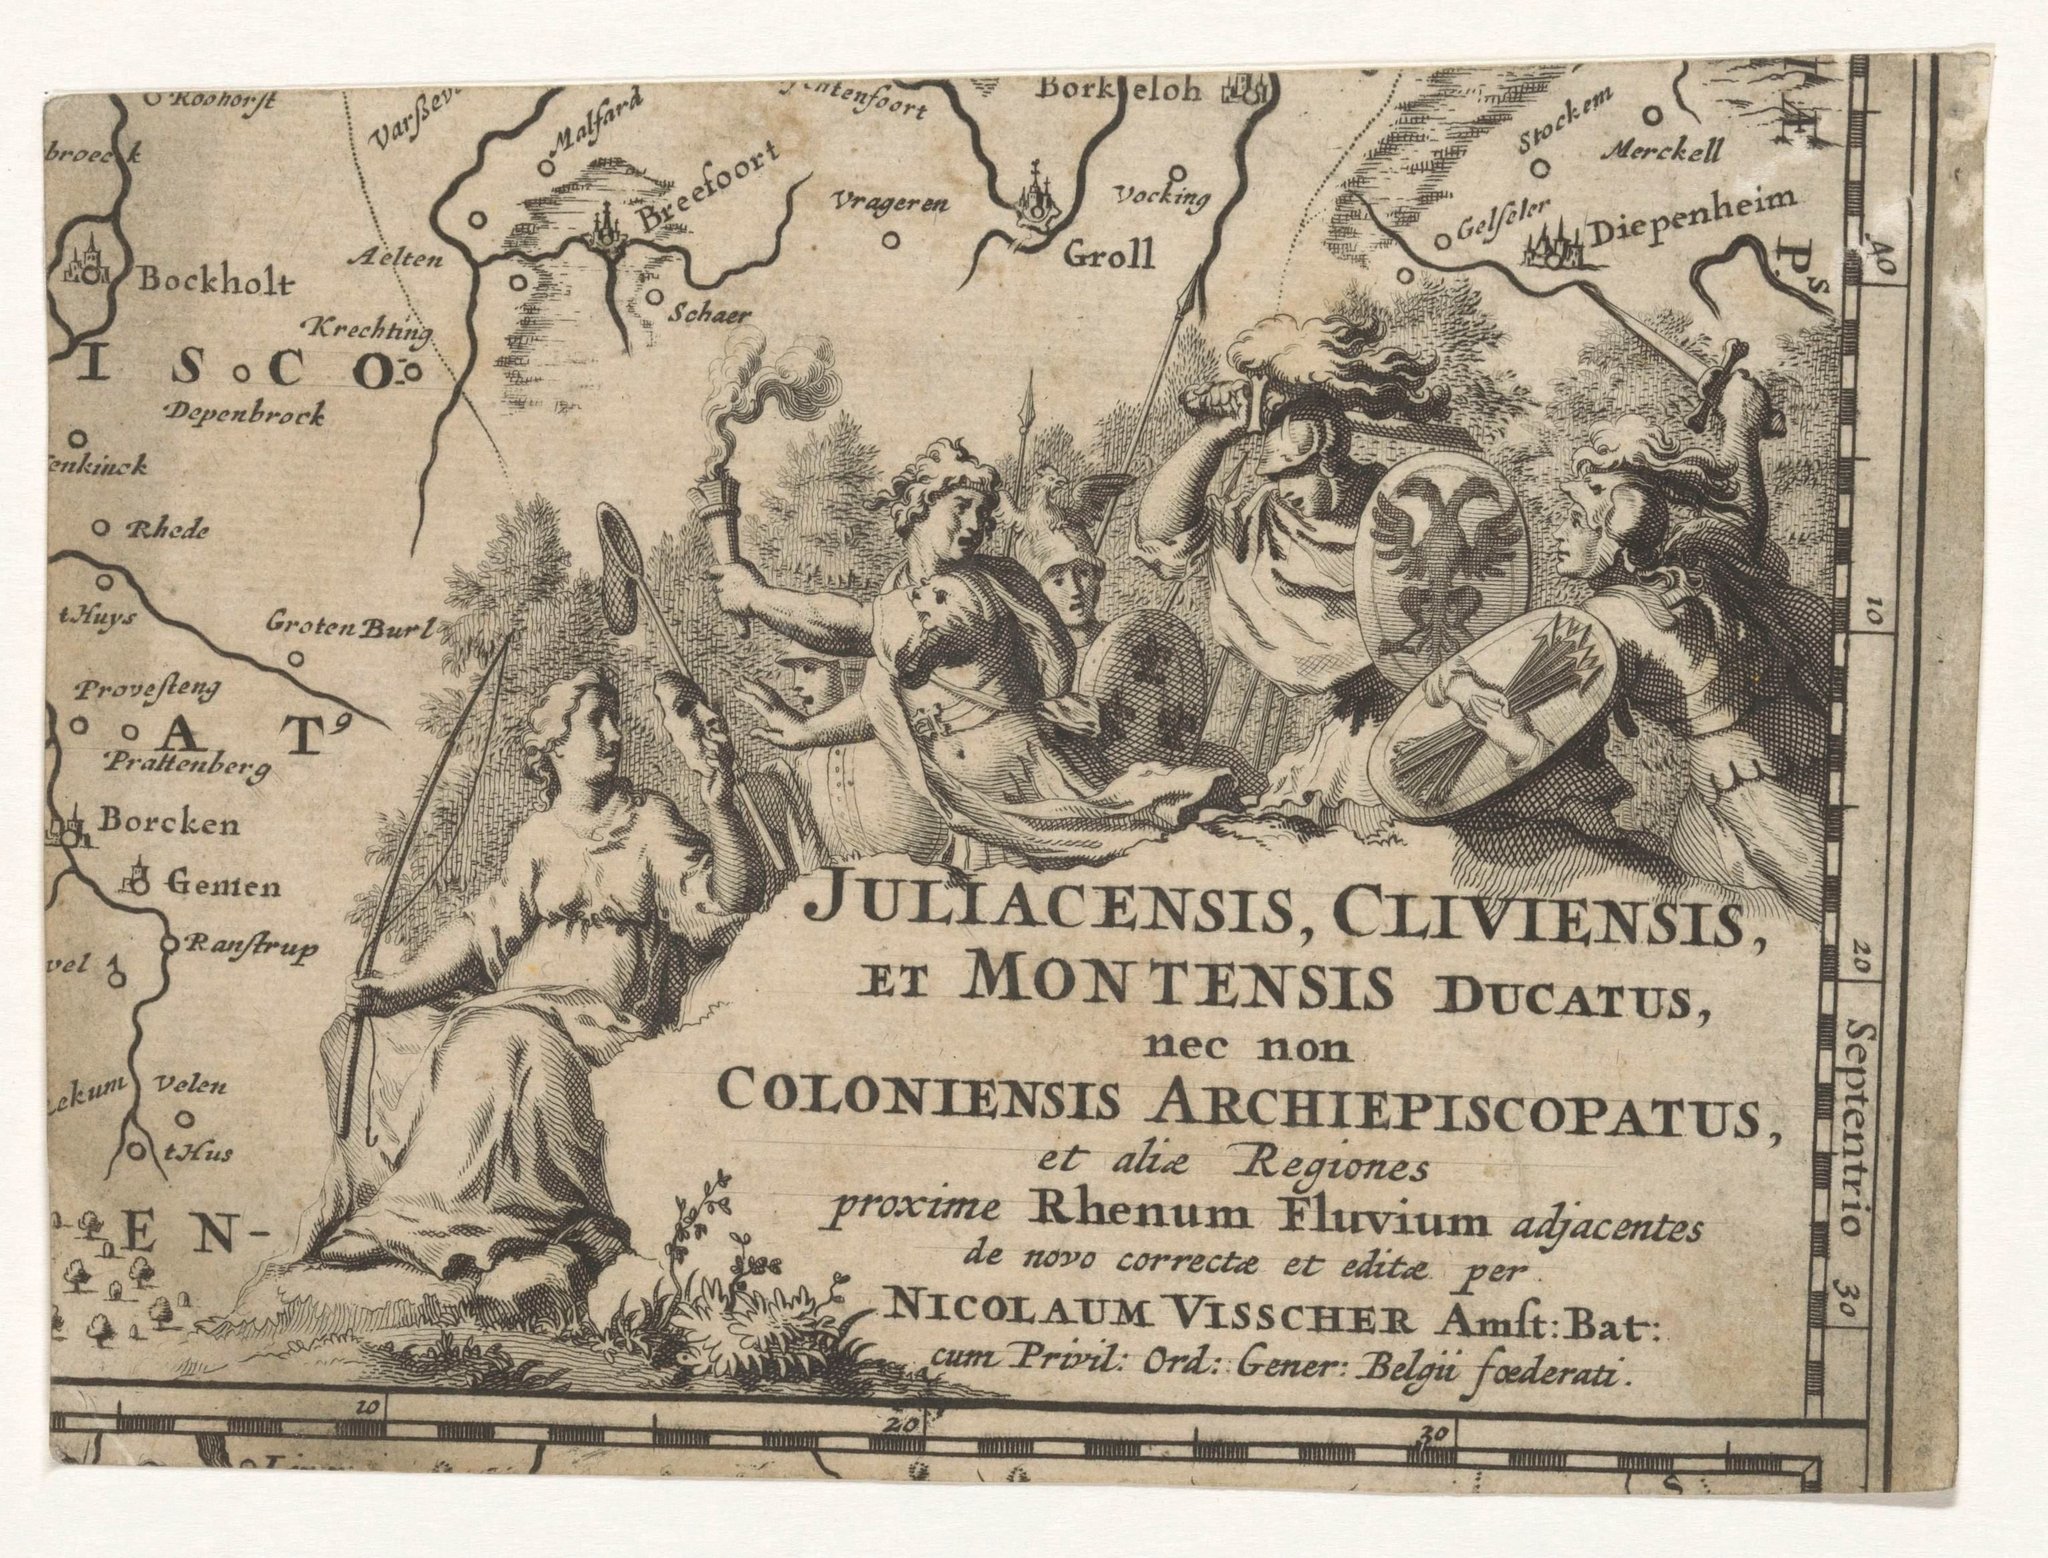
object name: print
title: Soldaten vallen allegorische figuren aan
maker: Anonymous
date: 1677-1702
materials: paper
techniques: engraving, etching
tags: (military) attack, the soldier; the soldier's life, germany, france, low countries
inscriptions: collector's mark: Lugt 2228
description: Twee soldaten met schilden waarop de wapens van het Duitse Rijk en de Nederlanden, vallen een figuur met fakkel aan. Een personificatie van Frankrijk met schild en helm met haan en een vrouw met hengel en masker kijken verschrikt toe. Detail van een kaart van West-Duitsland